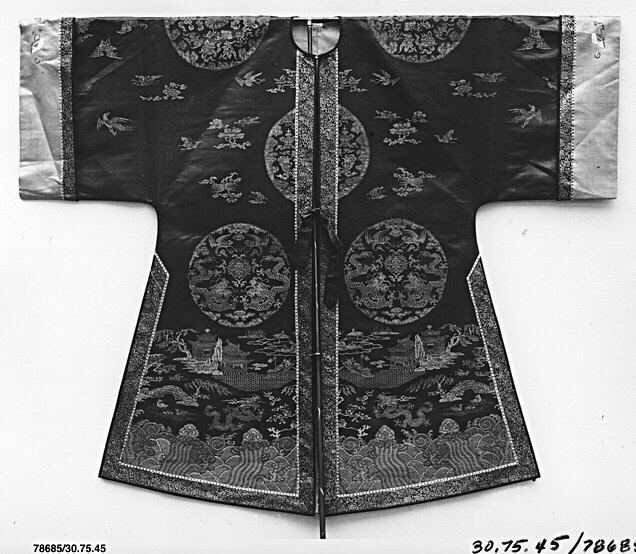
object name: coat, ceremonial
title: Ceremonial Coat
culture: chinese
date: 1801-1900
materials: metal thread, silk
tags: dragons